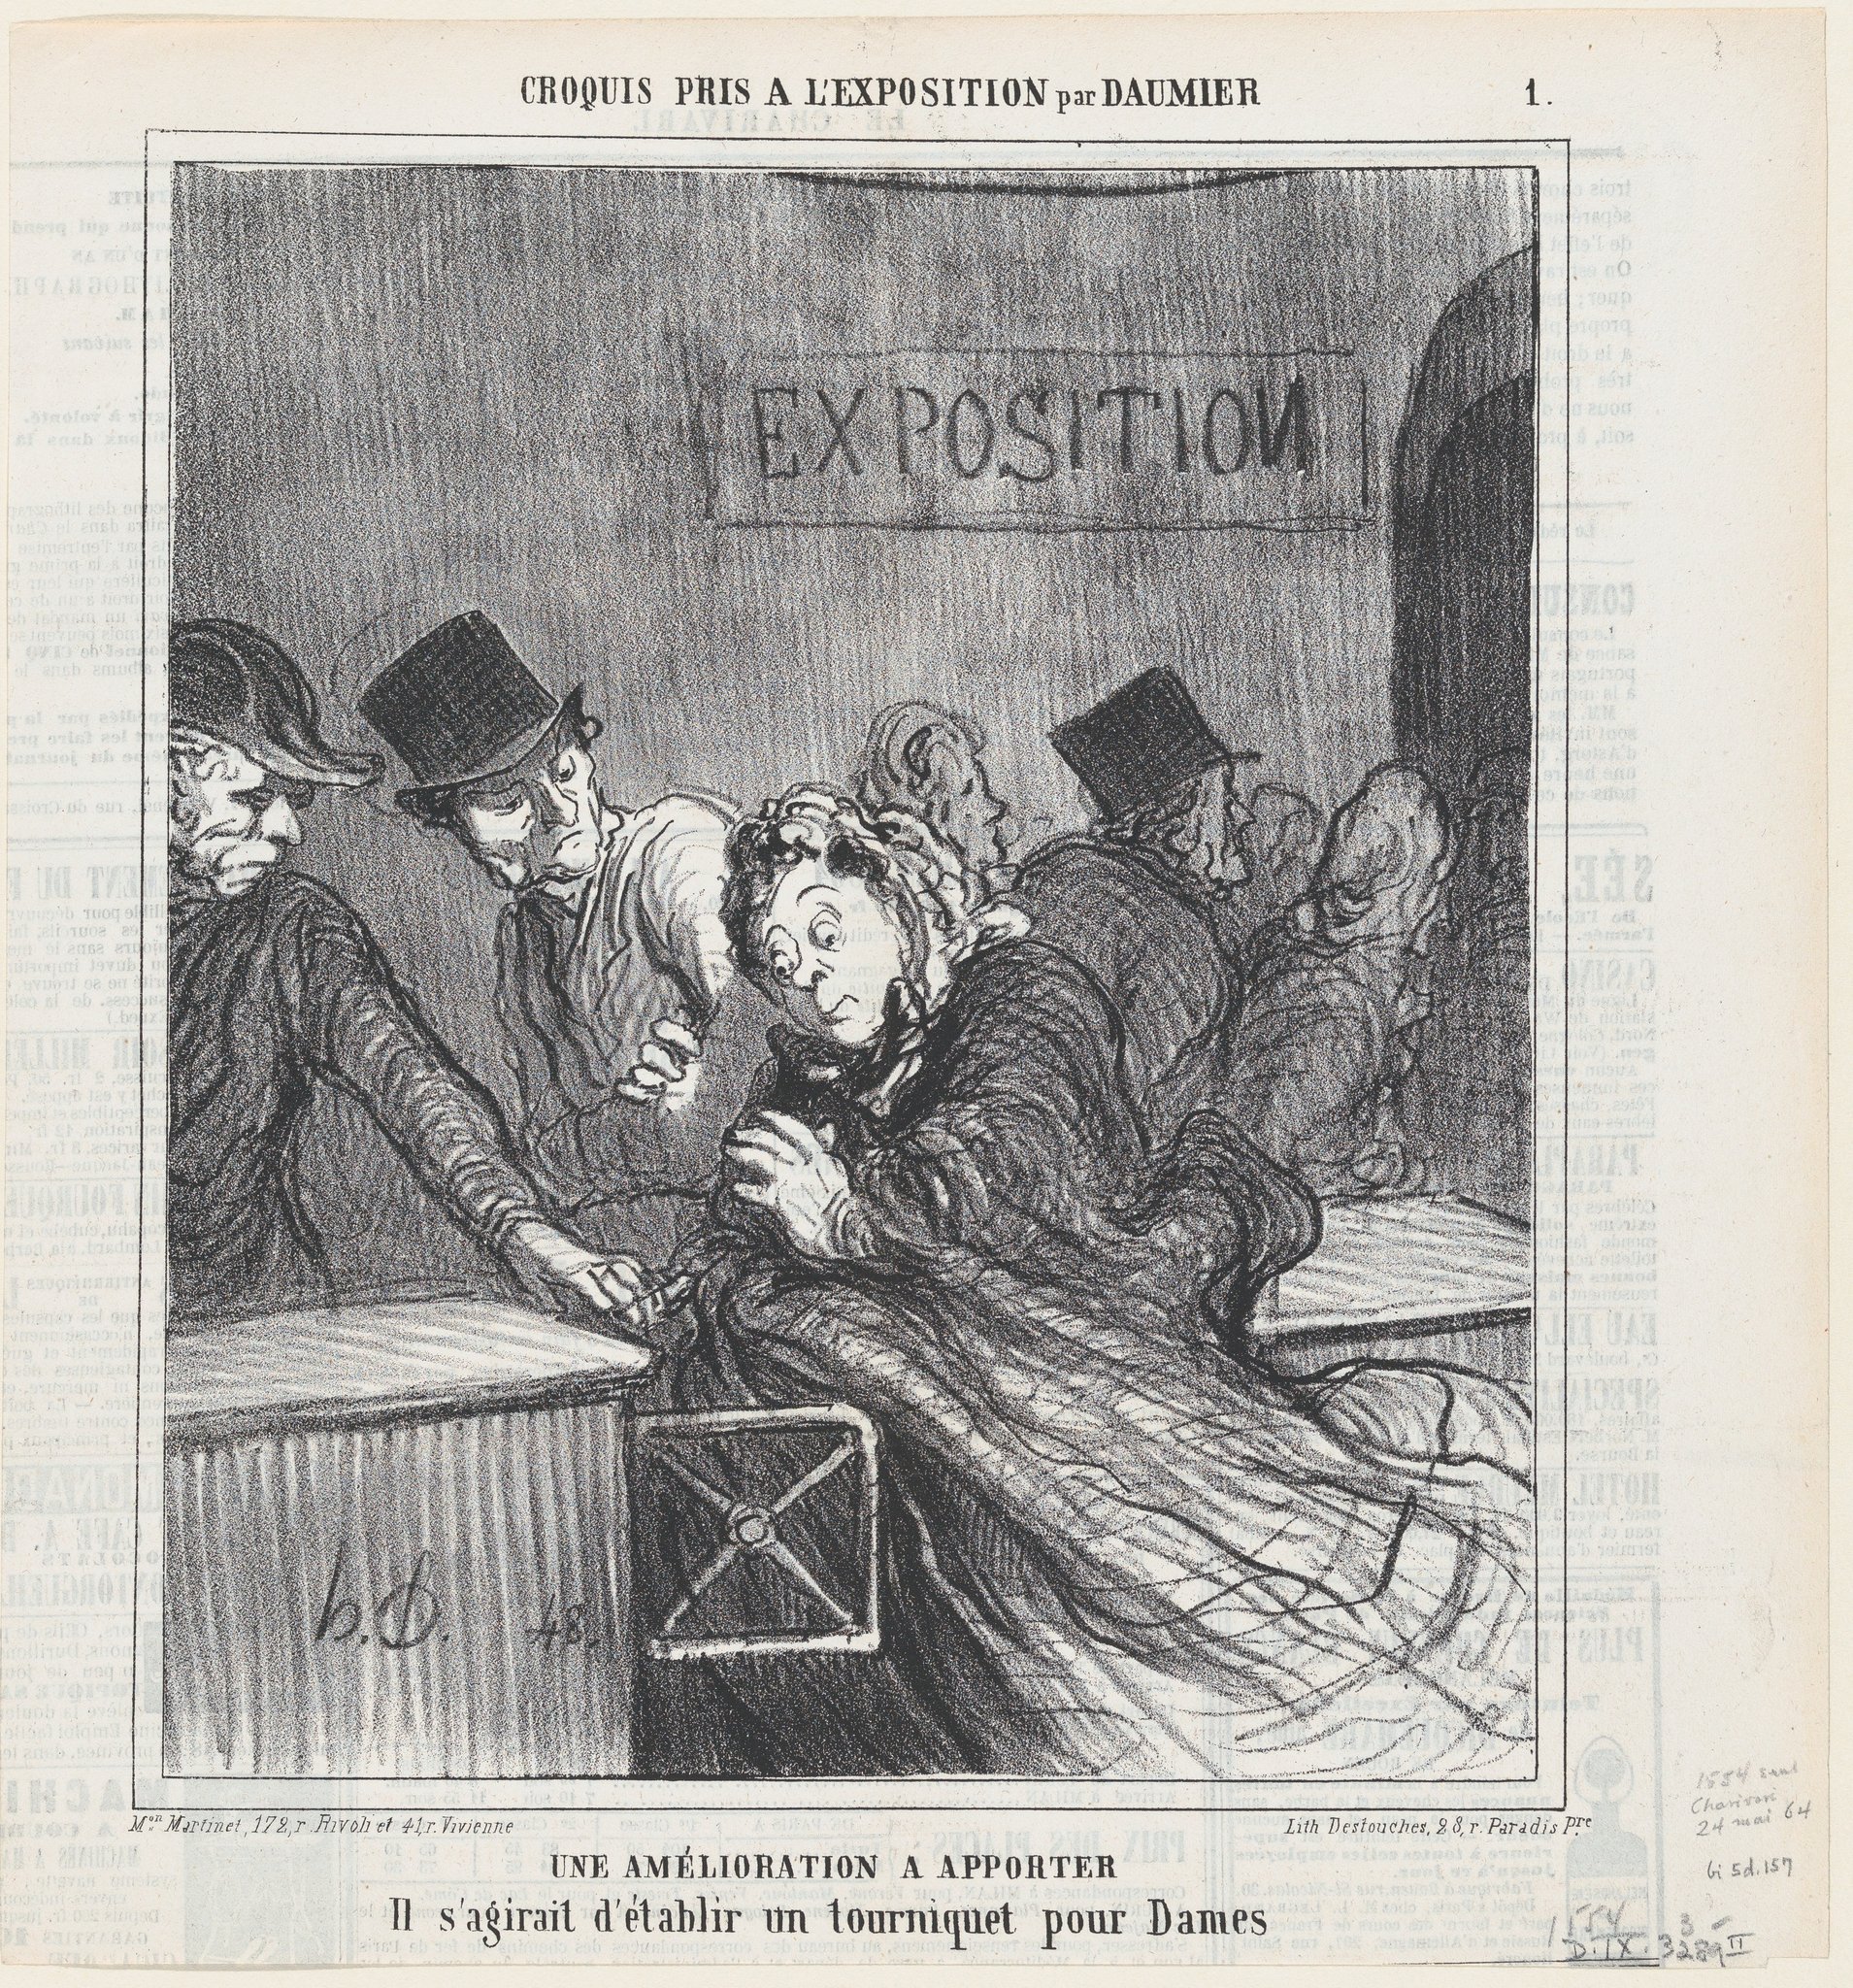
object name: print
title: Proposal for an improvement, from 'Exhibition sketches,' published in Le Charivari, May 24, 1864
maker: honoré daumier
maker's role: artist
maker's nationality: french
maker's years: 1808-1879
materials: paper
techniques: lithograph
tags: satire,men,women